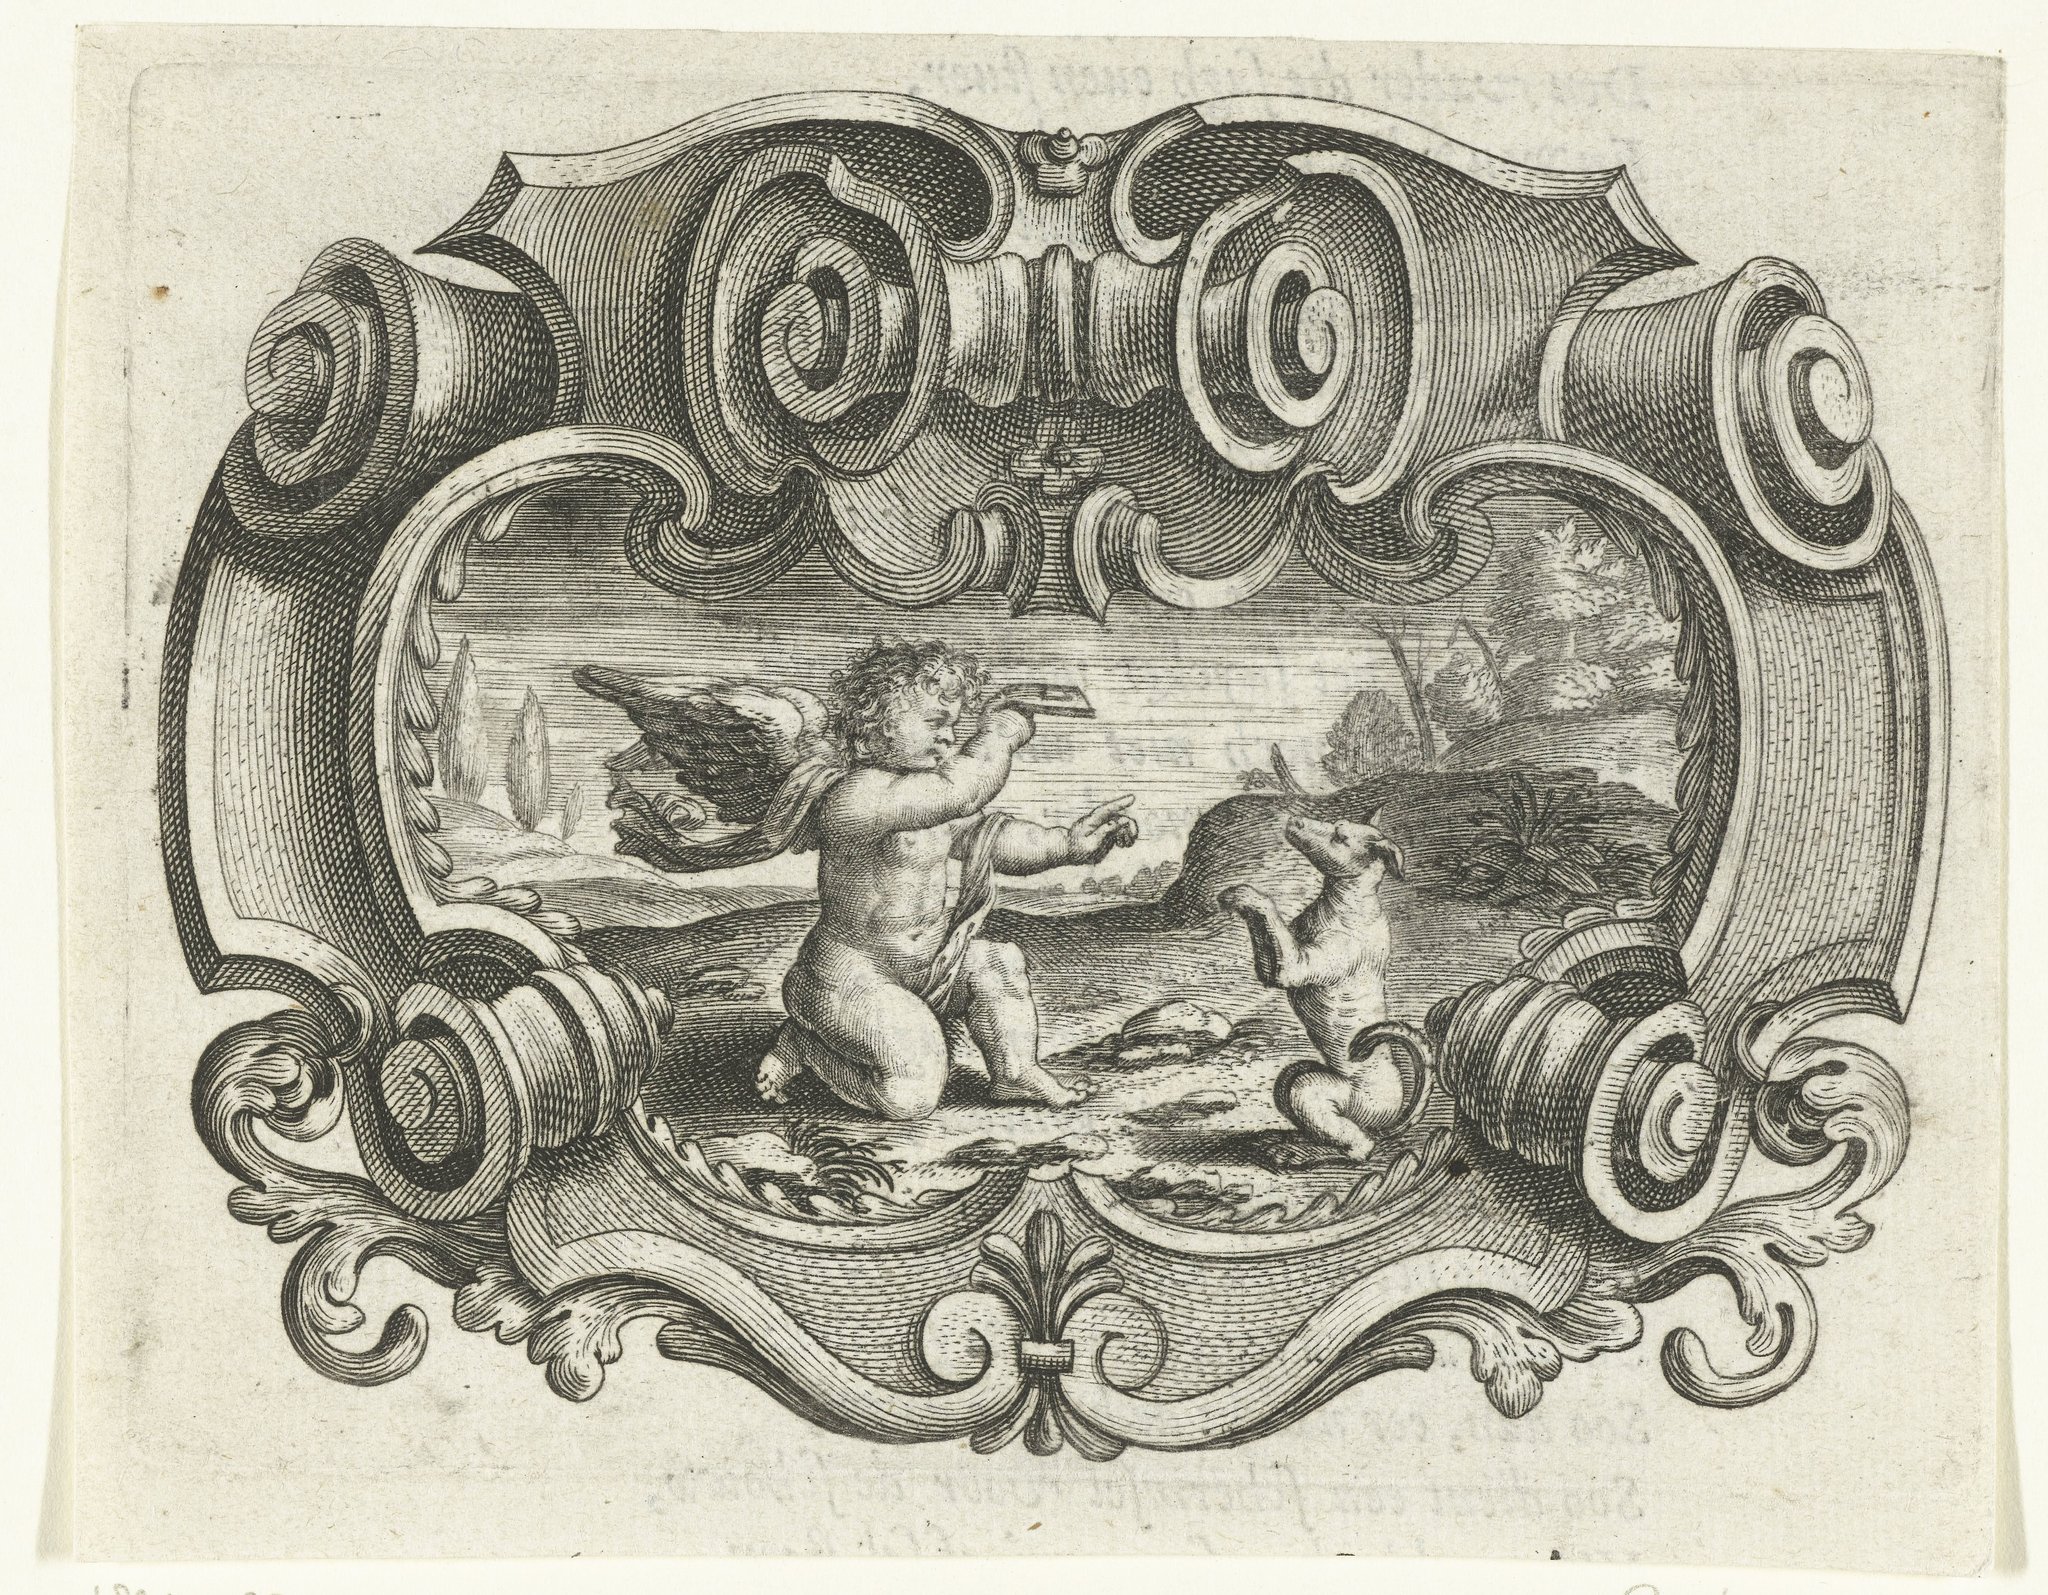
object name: print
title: Afbeeldinghe van d'eerste eeuwe der Societeit Iesv voor ooghen ghestelt door de Duyts-Nederlantsche Provincie der selver Societeyt.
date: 1640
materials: paper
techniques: engraving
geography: antwerp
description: Uit serie van 38 cartouches, gedecoreerd met maskers, guirlandes van fruit en bloemen, schelpen en dieren.